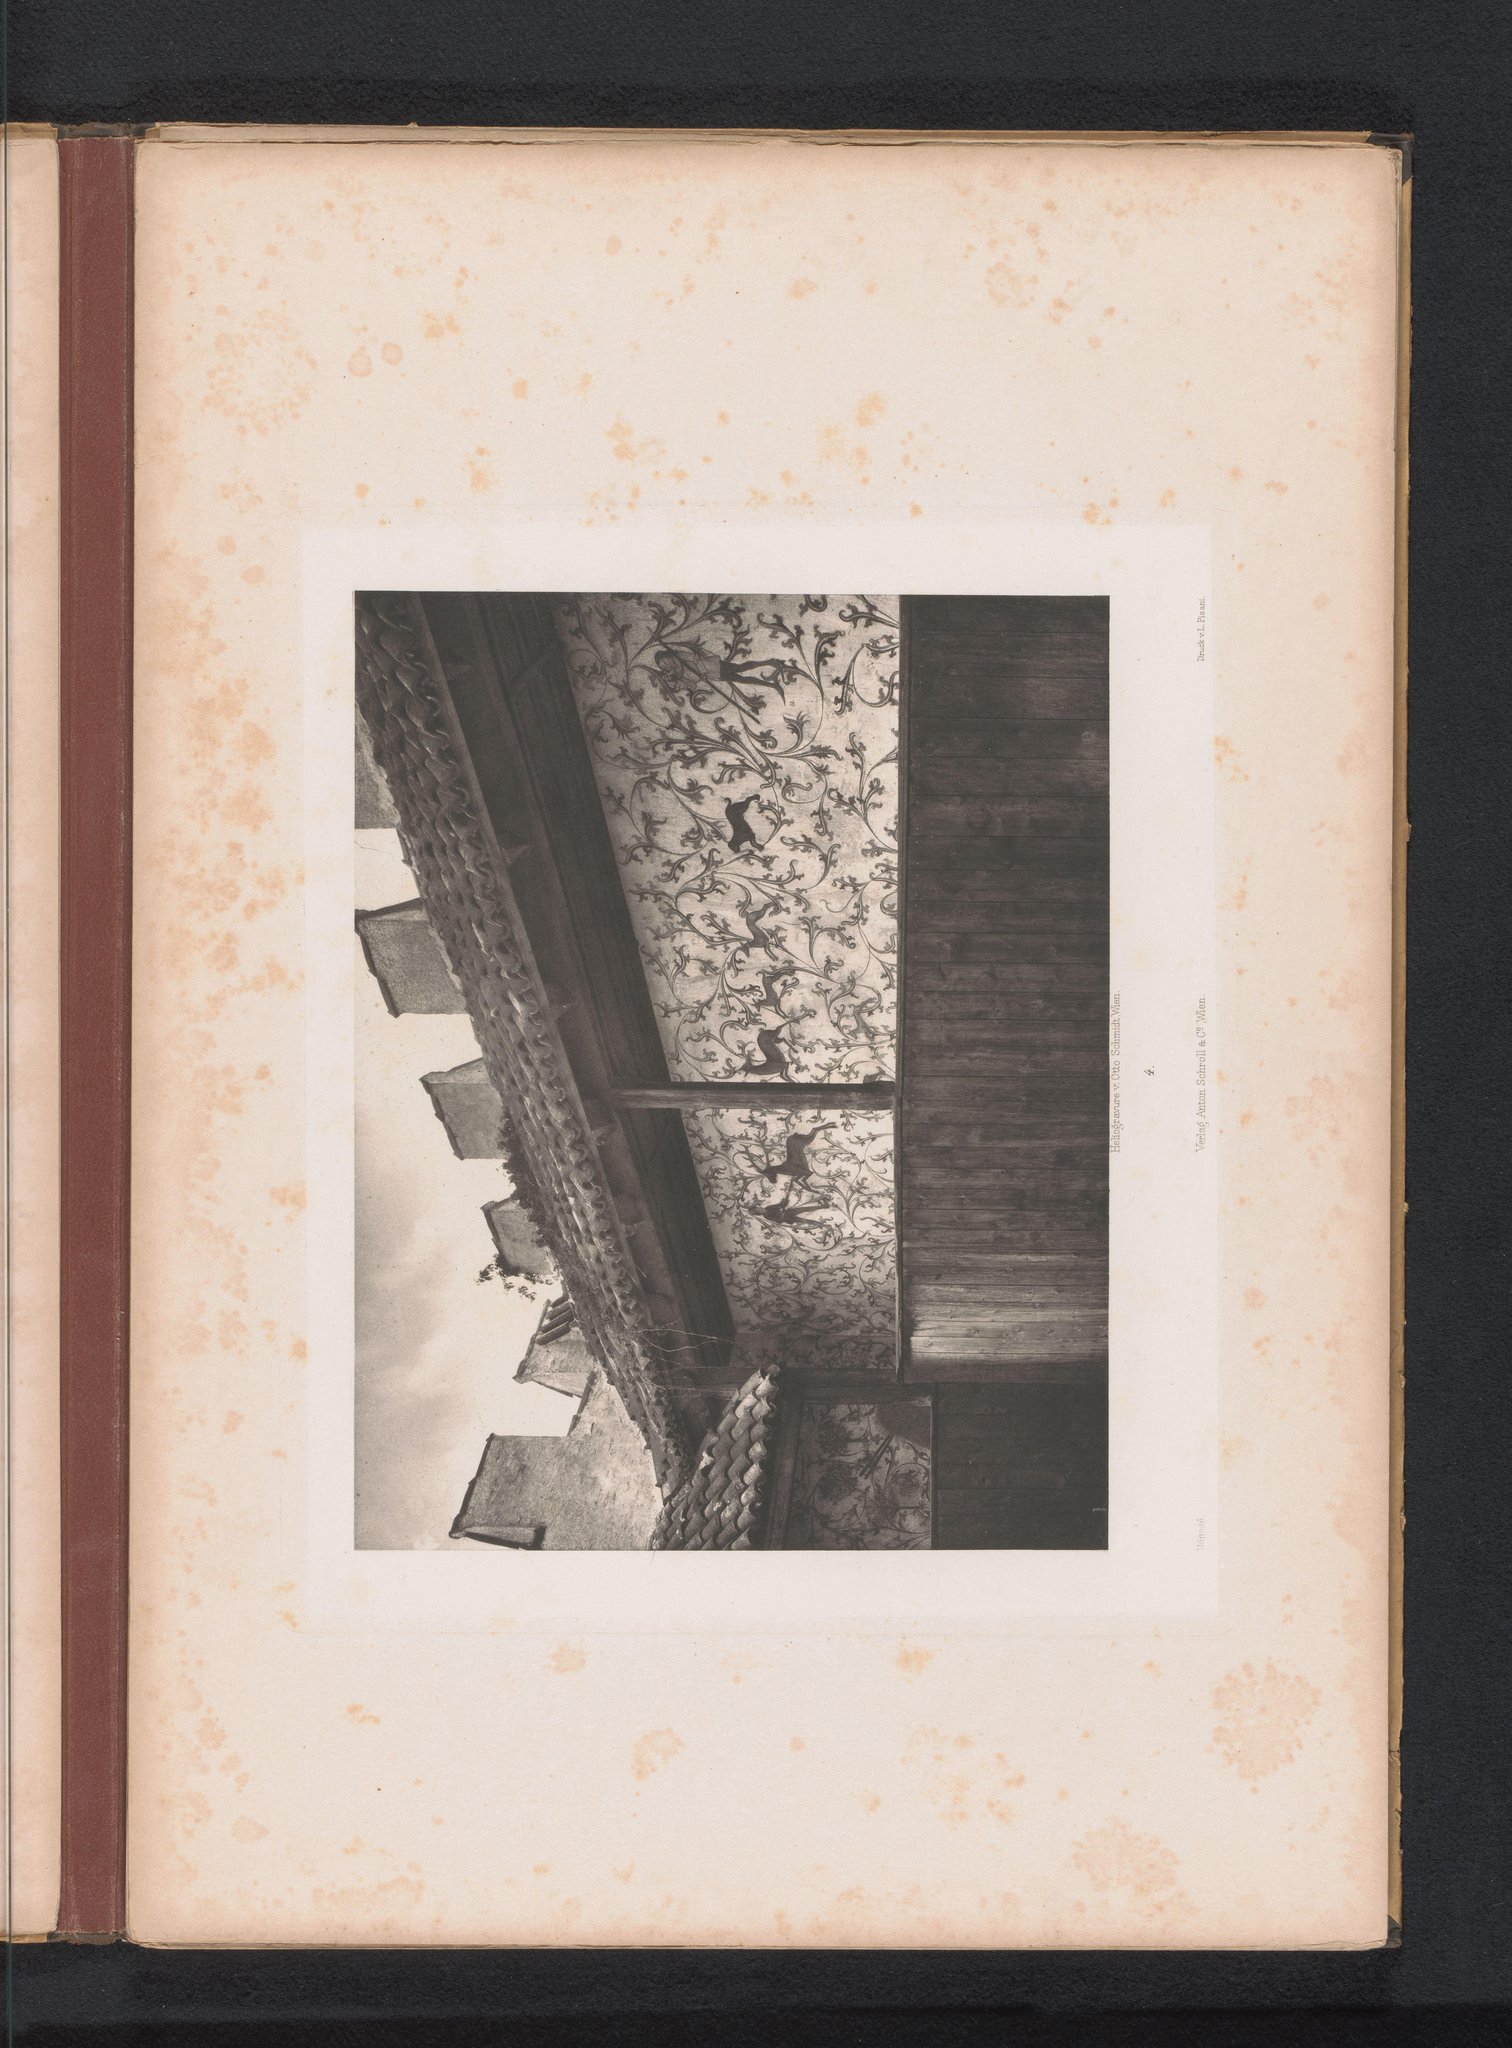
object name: photomechanical print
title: Fresco's aan de buitenzijde van Burcht Katzenstein in Merano, Italië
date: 1888-1893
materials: paper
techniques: photoaquatint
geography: vienna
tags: picture, painting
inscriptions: inscription: ‘Déposé.’, number: ‘4.’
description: Deze prent maakt deel uit van een omslag met twintig prenten, twee tekstbladen en een titelpagina.